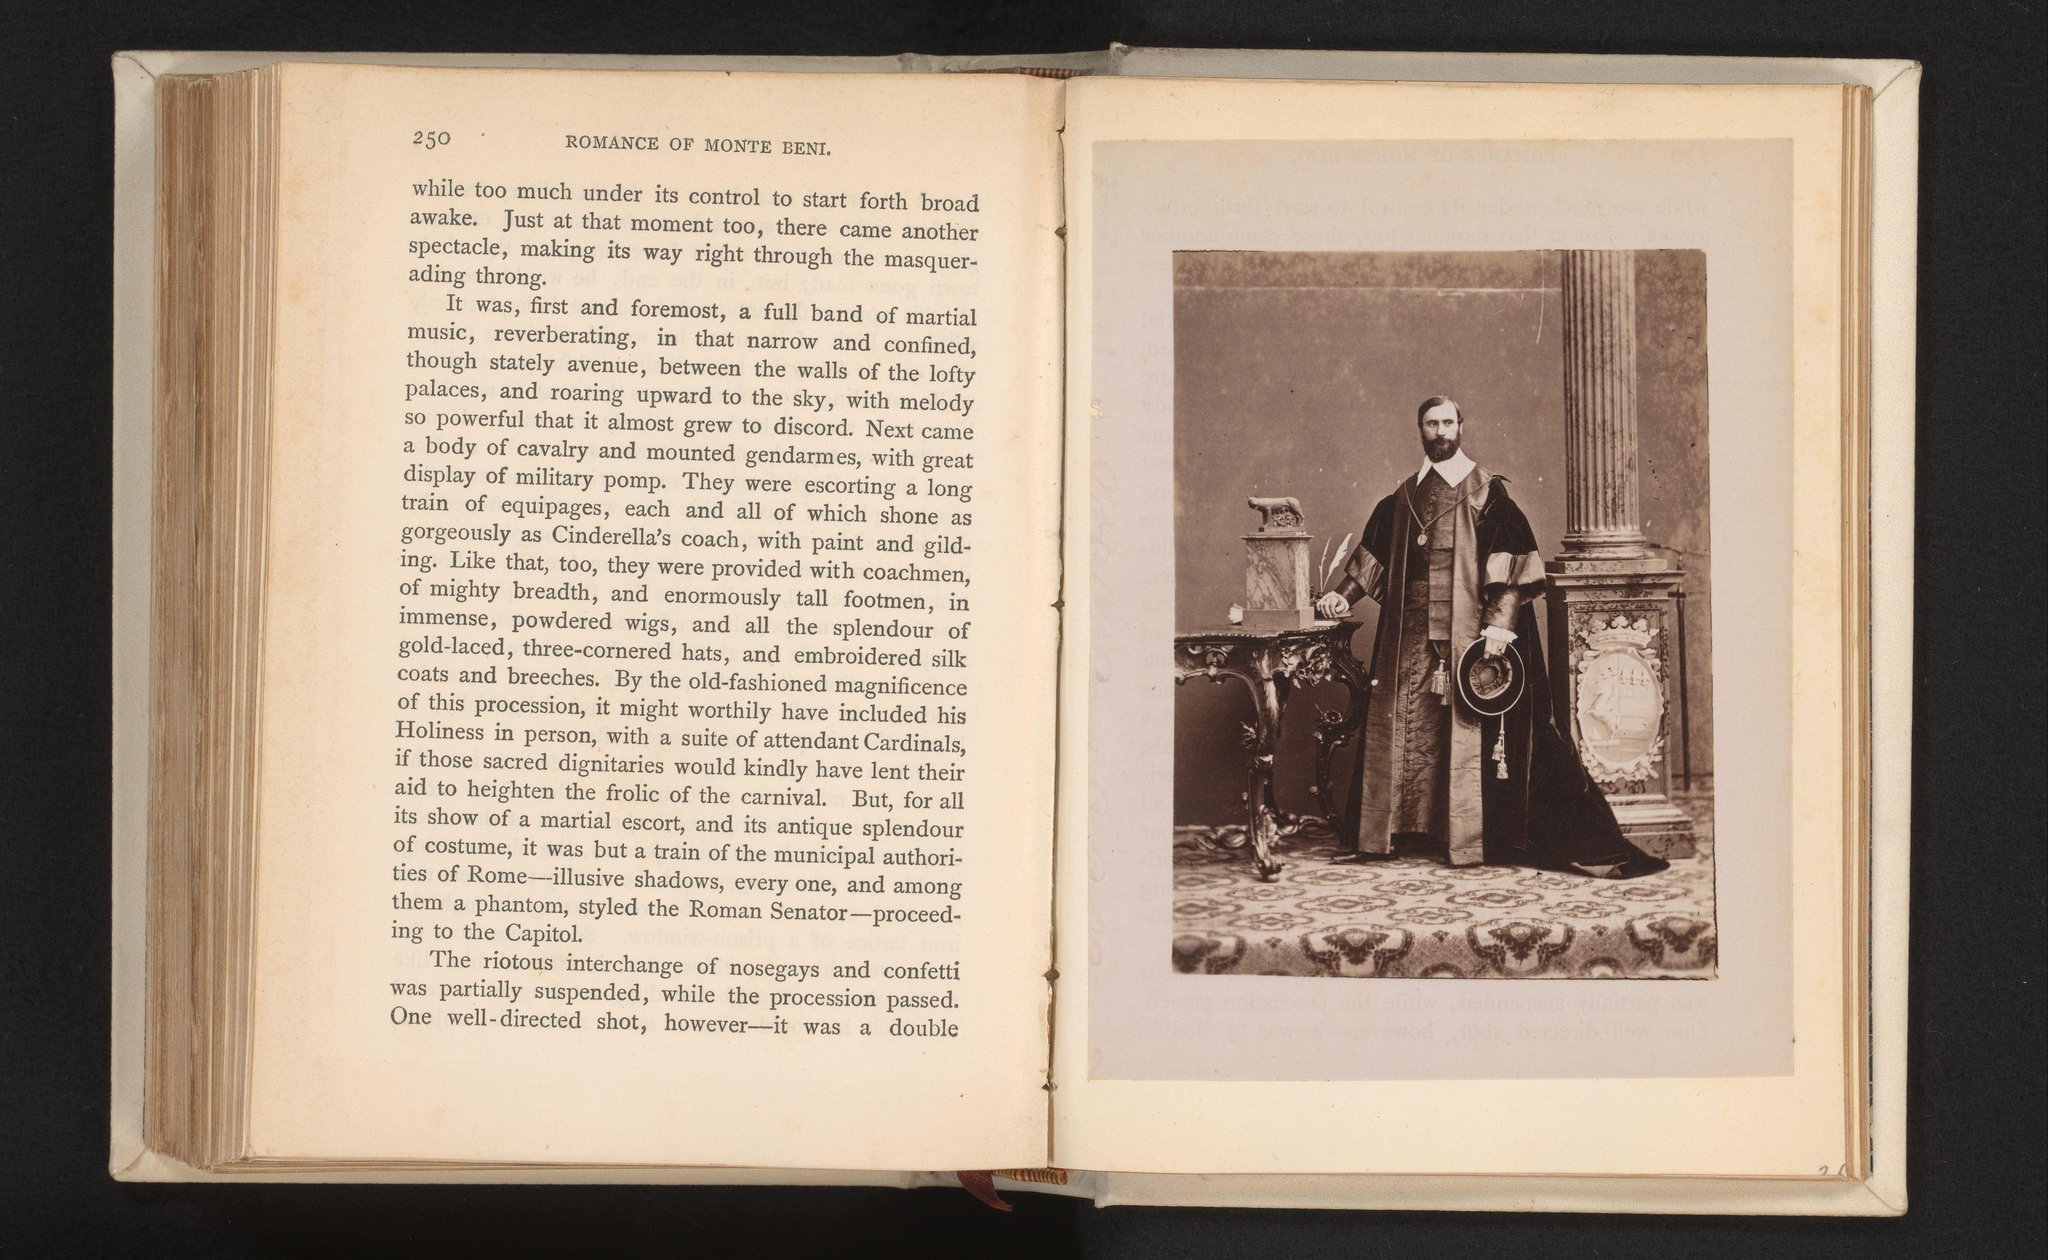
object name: photograph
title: Portret van een onbekende man in vermoedelijk een historisch kostuum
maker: Anonymous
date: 1850-1860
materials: photographic support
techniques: albumen print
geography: italy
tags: historical costume, historical persons not known by name